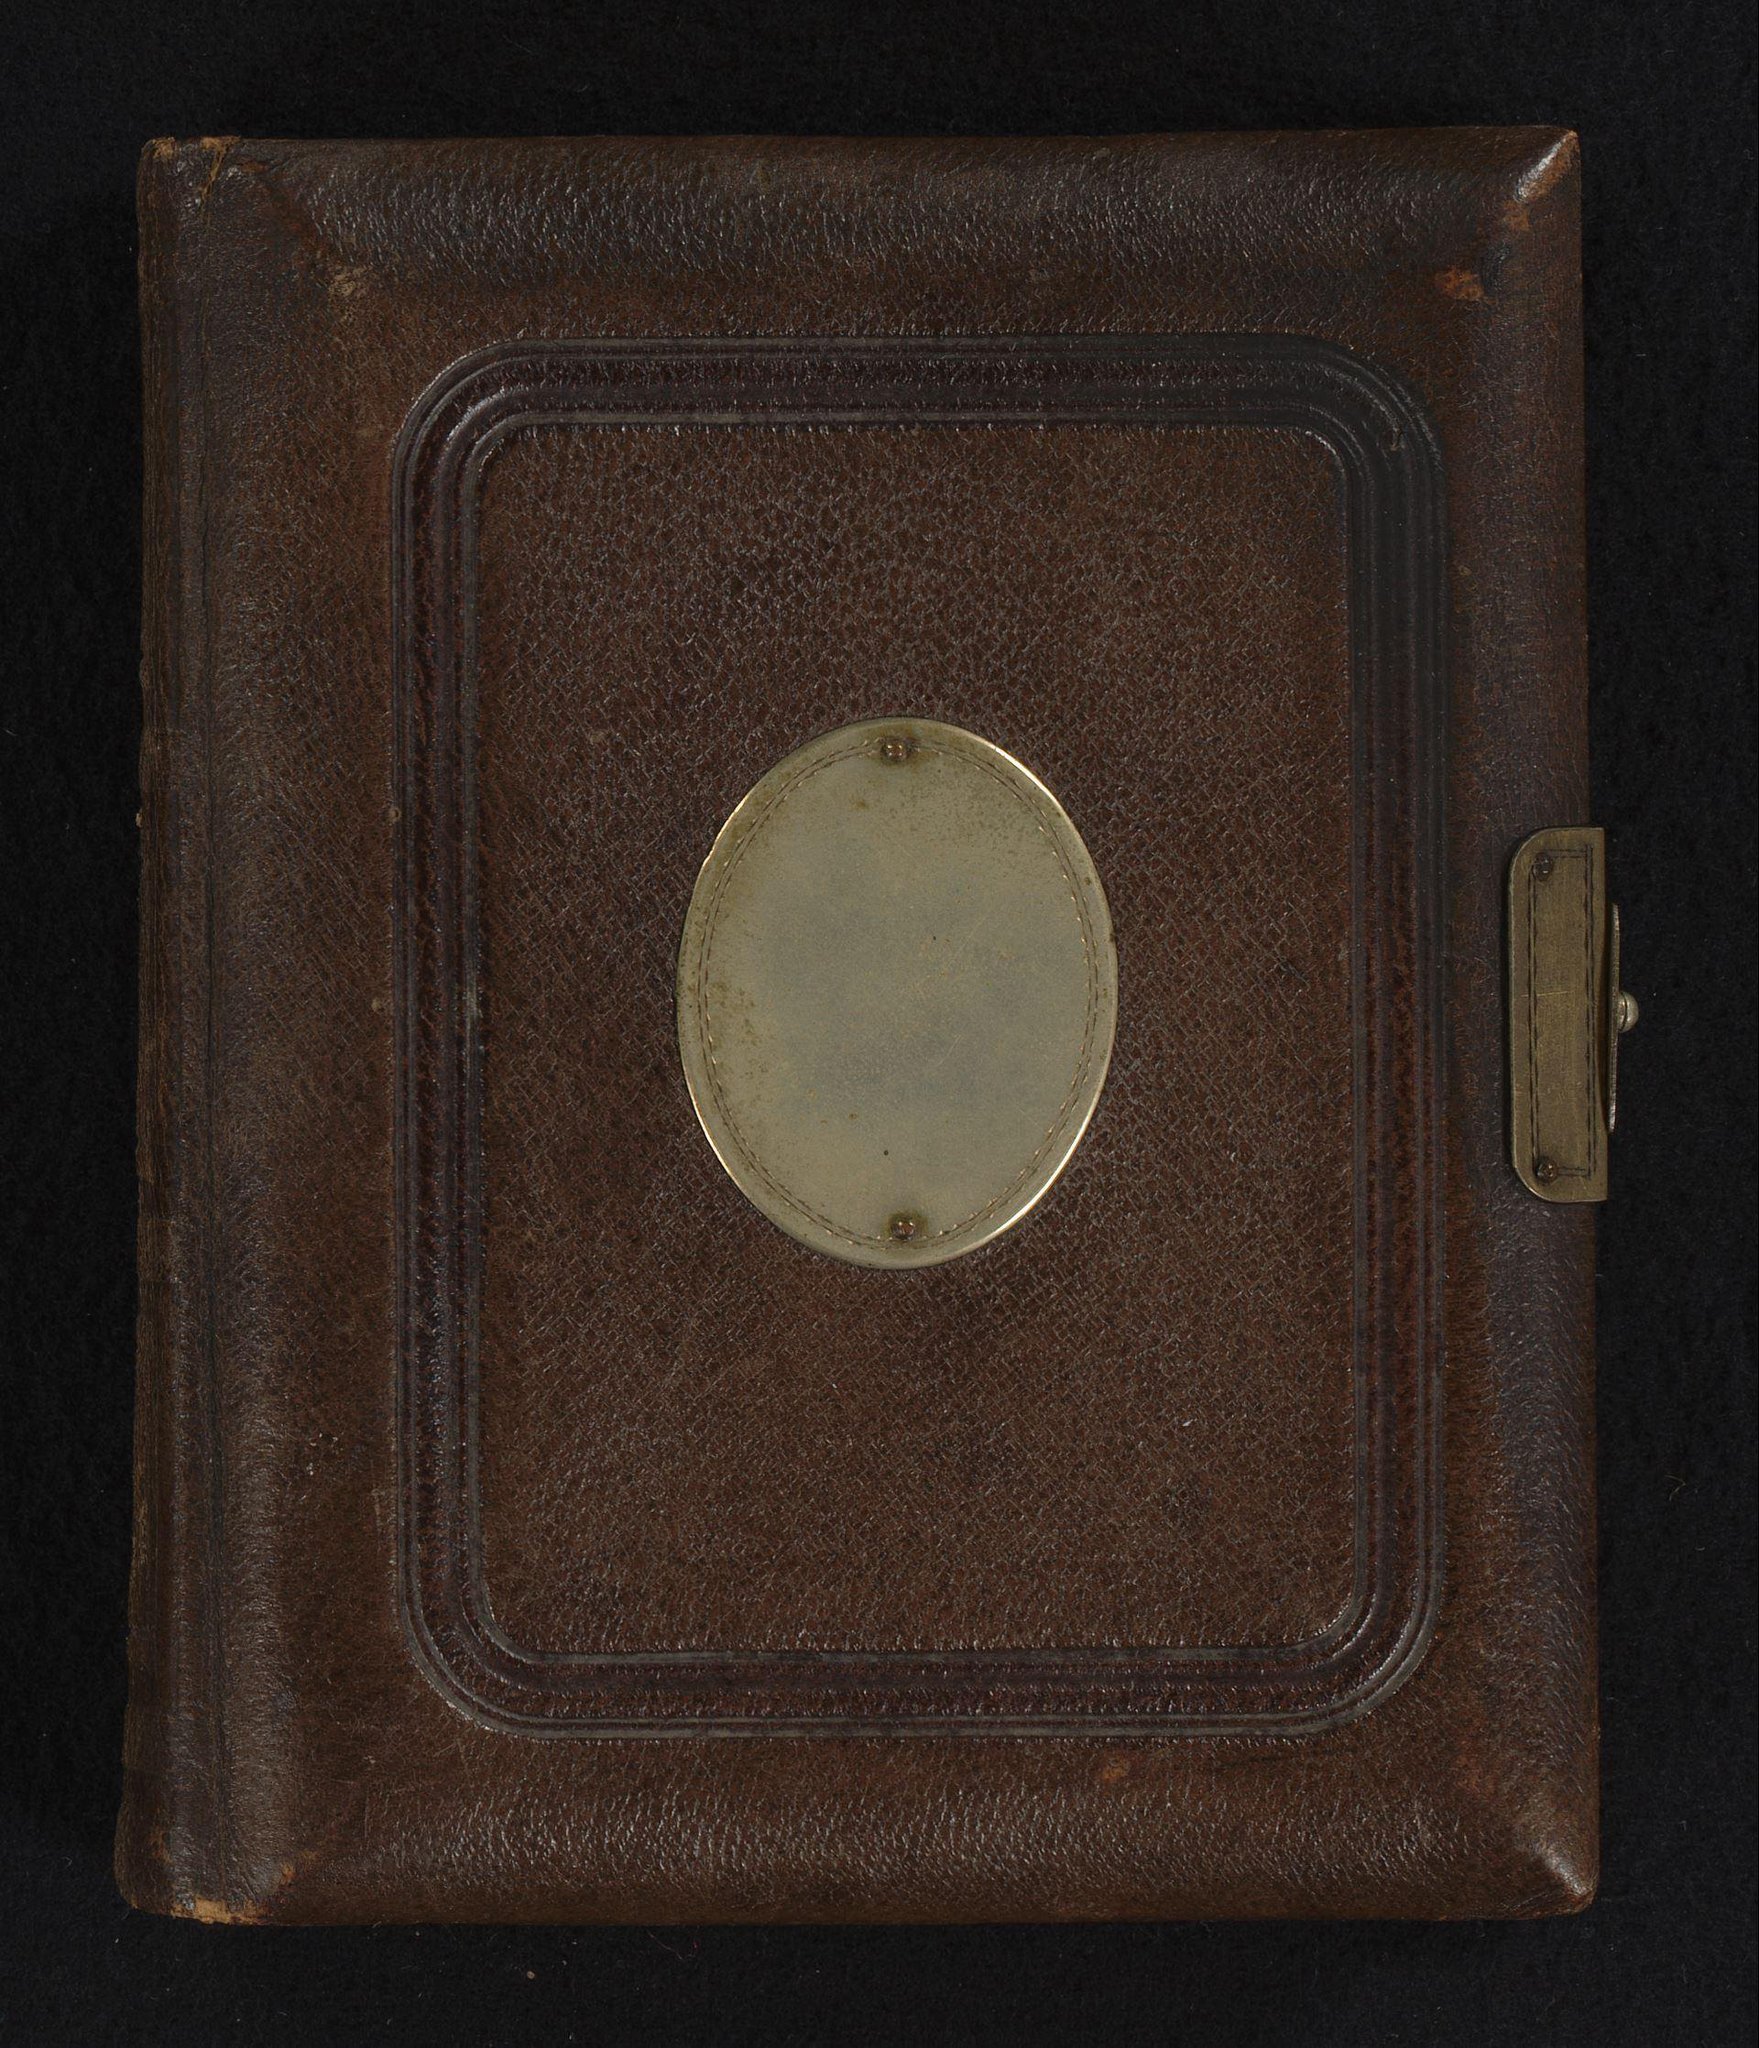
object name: photograph album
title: Fotoalbum (leeg)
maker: Anonymous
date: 1860-1900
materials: cardboard, leather, metal, paper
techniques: color on snow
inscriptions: collector's mark: ‘DIENST/ VERSPREIDE/ RIJKSKOLLEKTIES/ (...) A 744’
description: Fotoalbum met 48 pagina's met ieder een met gouden lijnen omkaderde passe-partout voor een carte-de-visite.